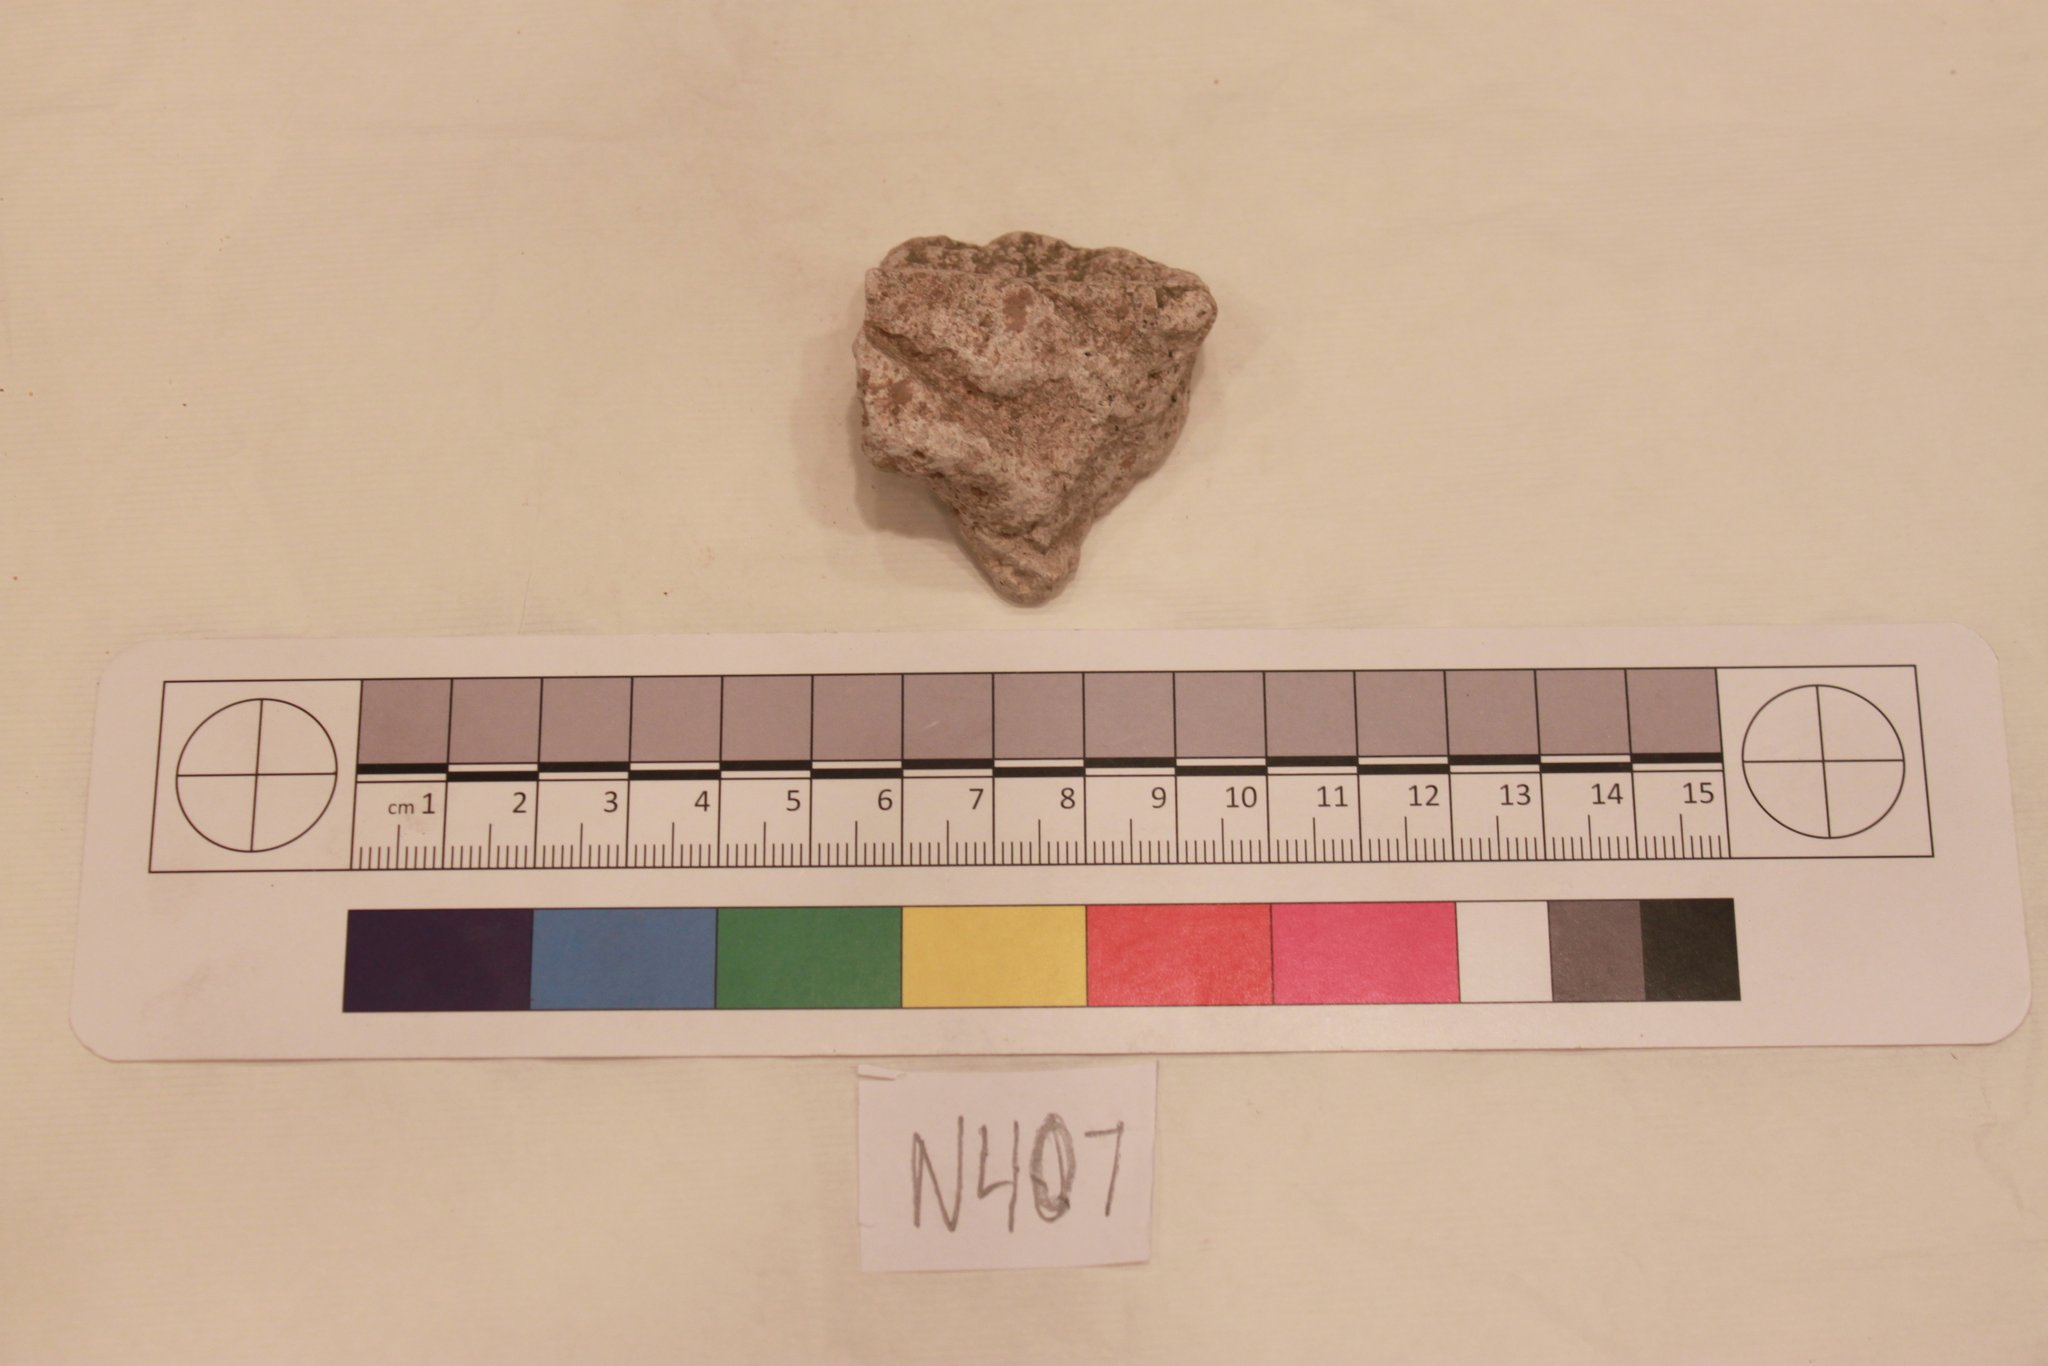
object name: fragment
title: Stucco Fragment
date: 701-1200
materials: plaster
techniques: carving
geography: iran